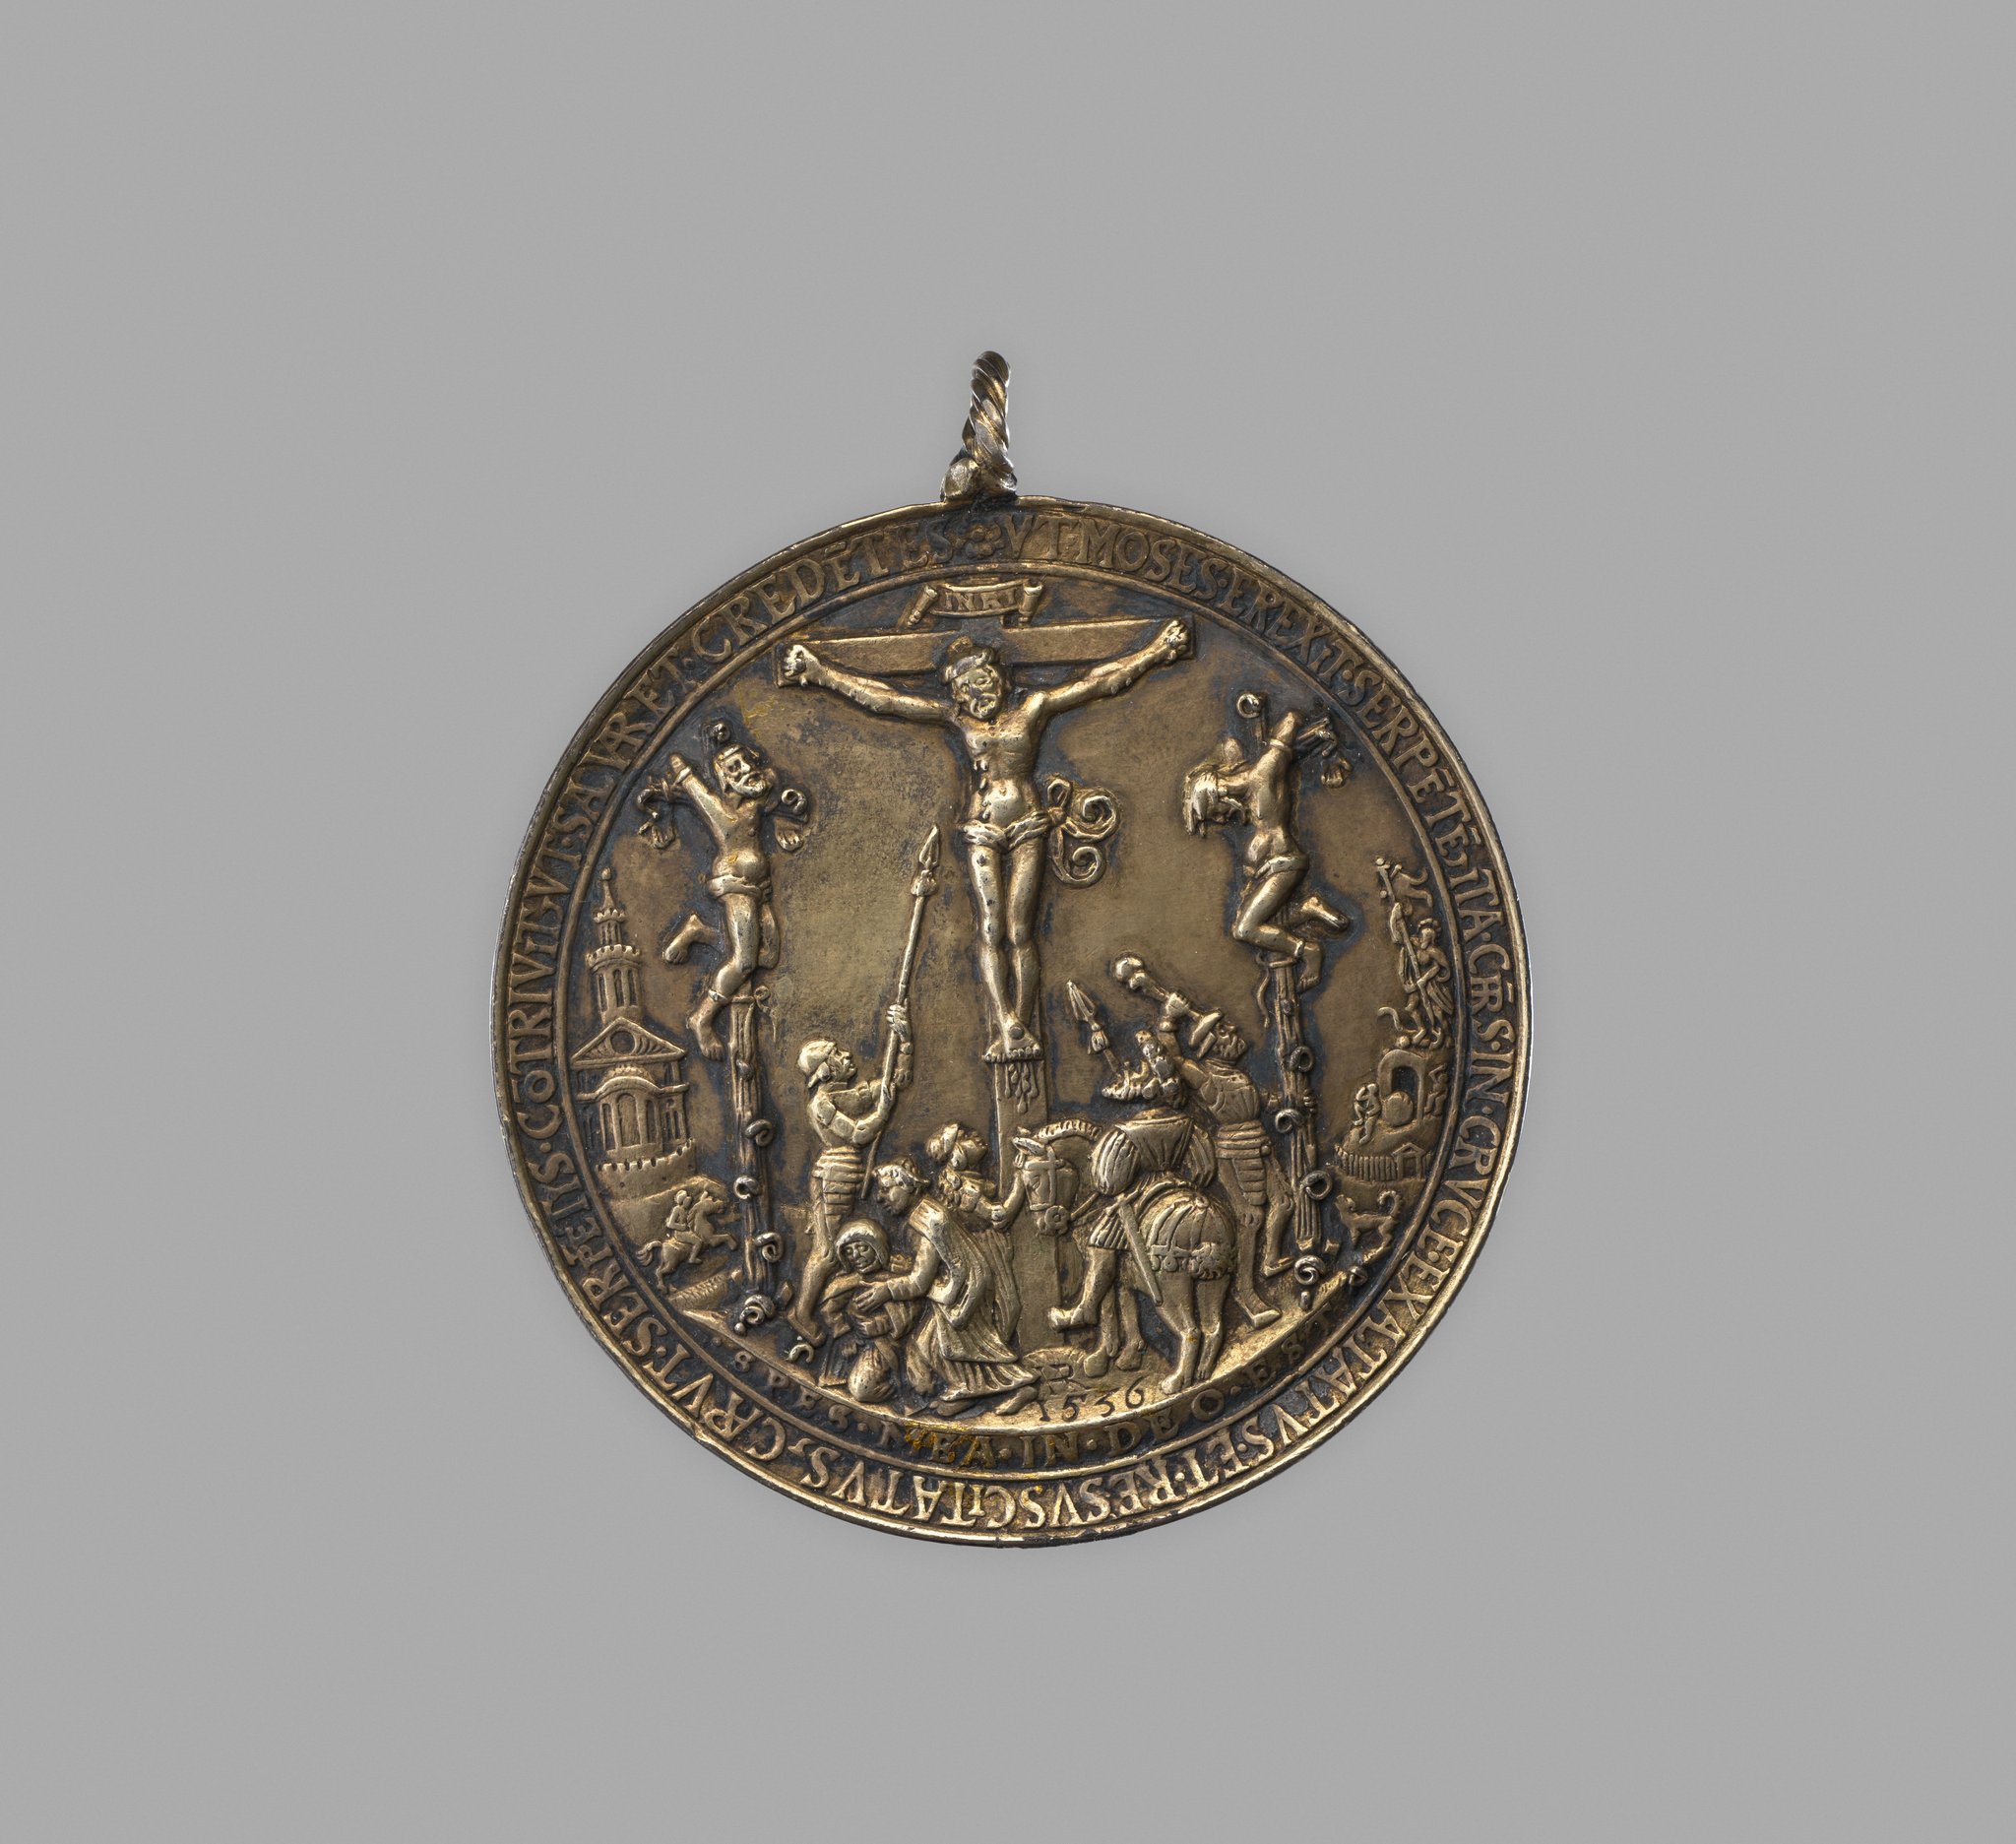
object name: medal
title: The Temptation of Adam and Eve and The Crucifixion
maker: hans reinhart the elder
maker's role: artist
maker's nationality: german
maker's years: 1500-1581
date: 1536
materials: gilt, silver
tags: animals,fruit,trees,adam,eve